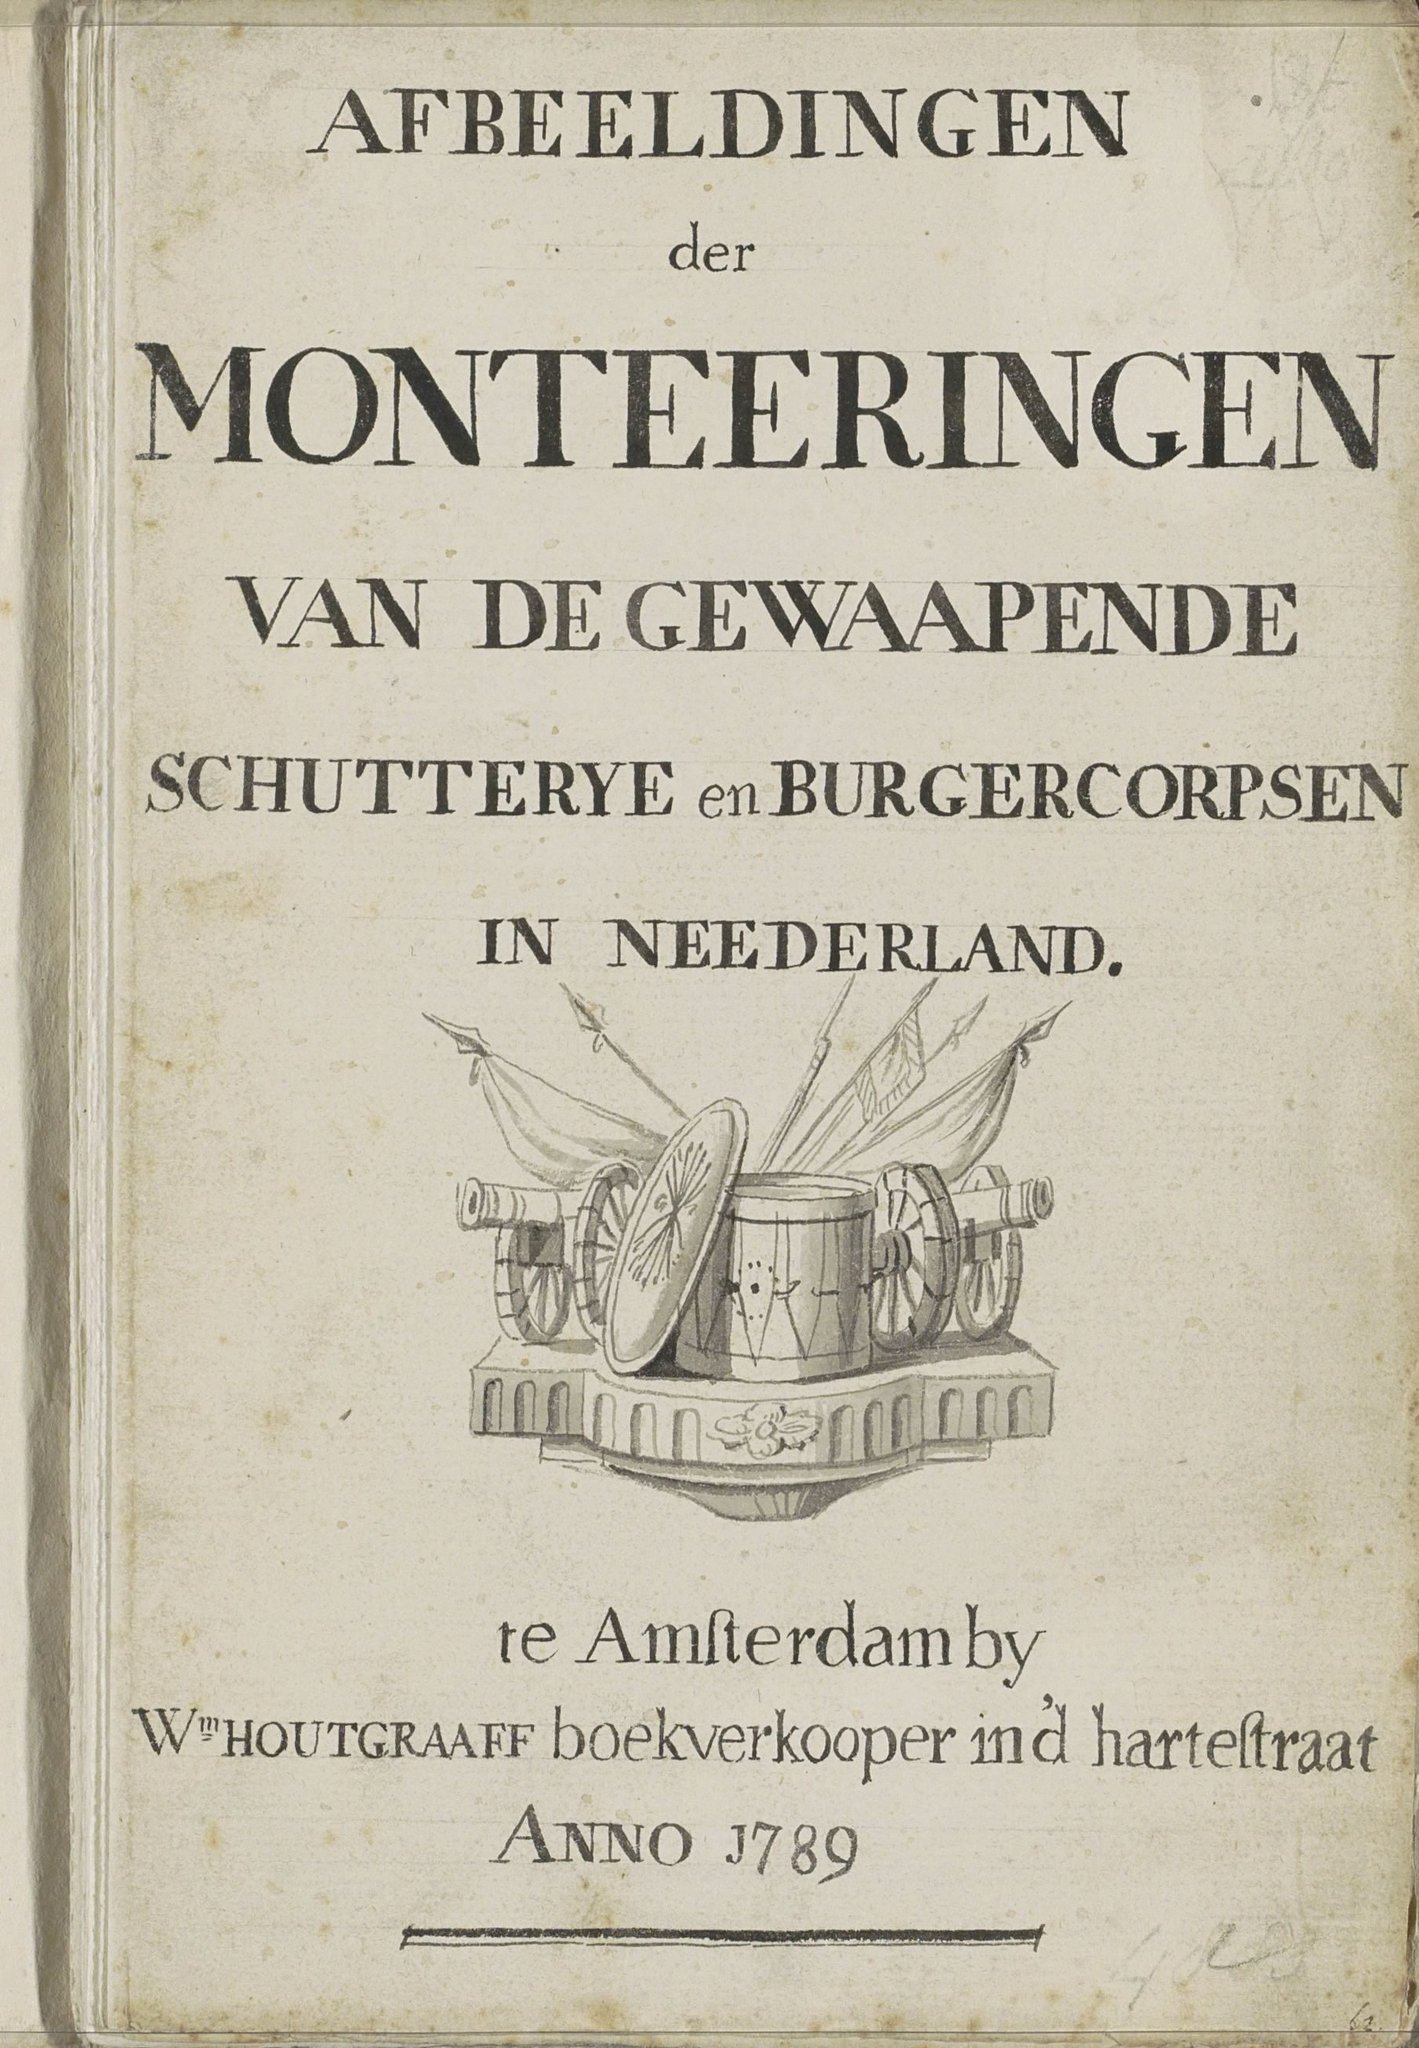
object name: titelblad, titelpagina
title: Afbeeldingen der Monteeringen van de gewaapende Schutterye en Burgercorpsen in Neederland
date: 1789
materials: paper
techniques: writing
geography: amsterdam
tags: (military) uniforms (+ citizen soldiery, civil guard, citizen militia), patriots (1780-1795)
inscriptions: collector's mark: Lugt 2166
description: Titelblad met handgeschreven titel en vignet van wapens en vaandels. Onderdeel van een schetsboek met 41 gekleurde tekeningen van de monteringen van de gewapende schutterijen en burgercorpsen in Nederland, 1789.